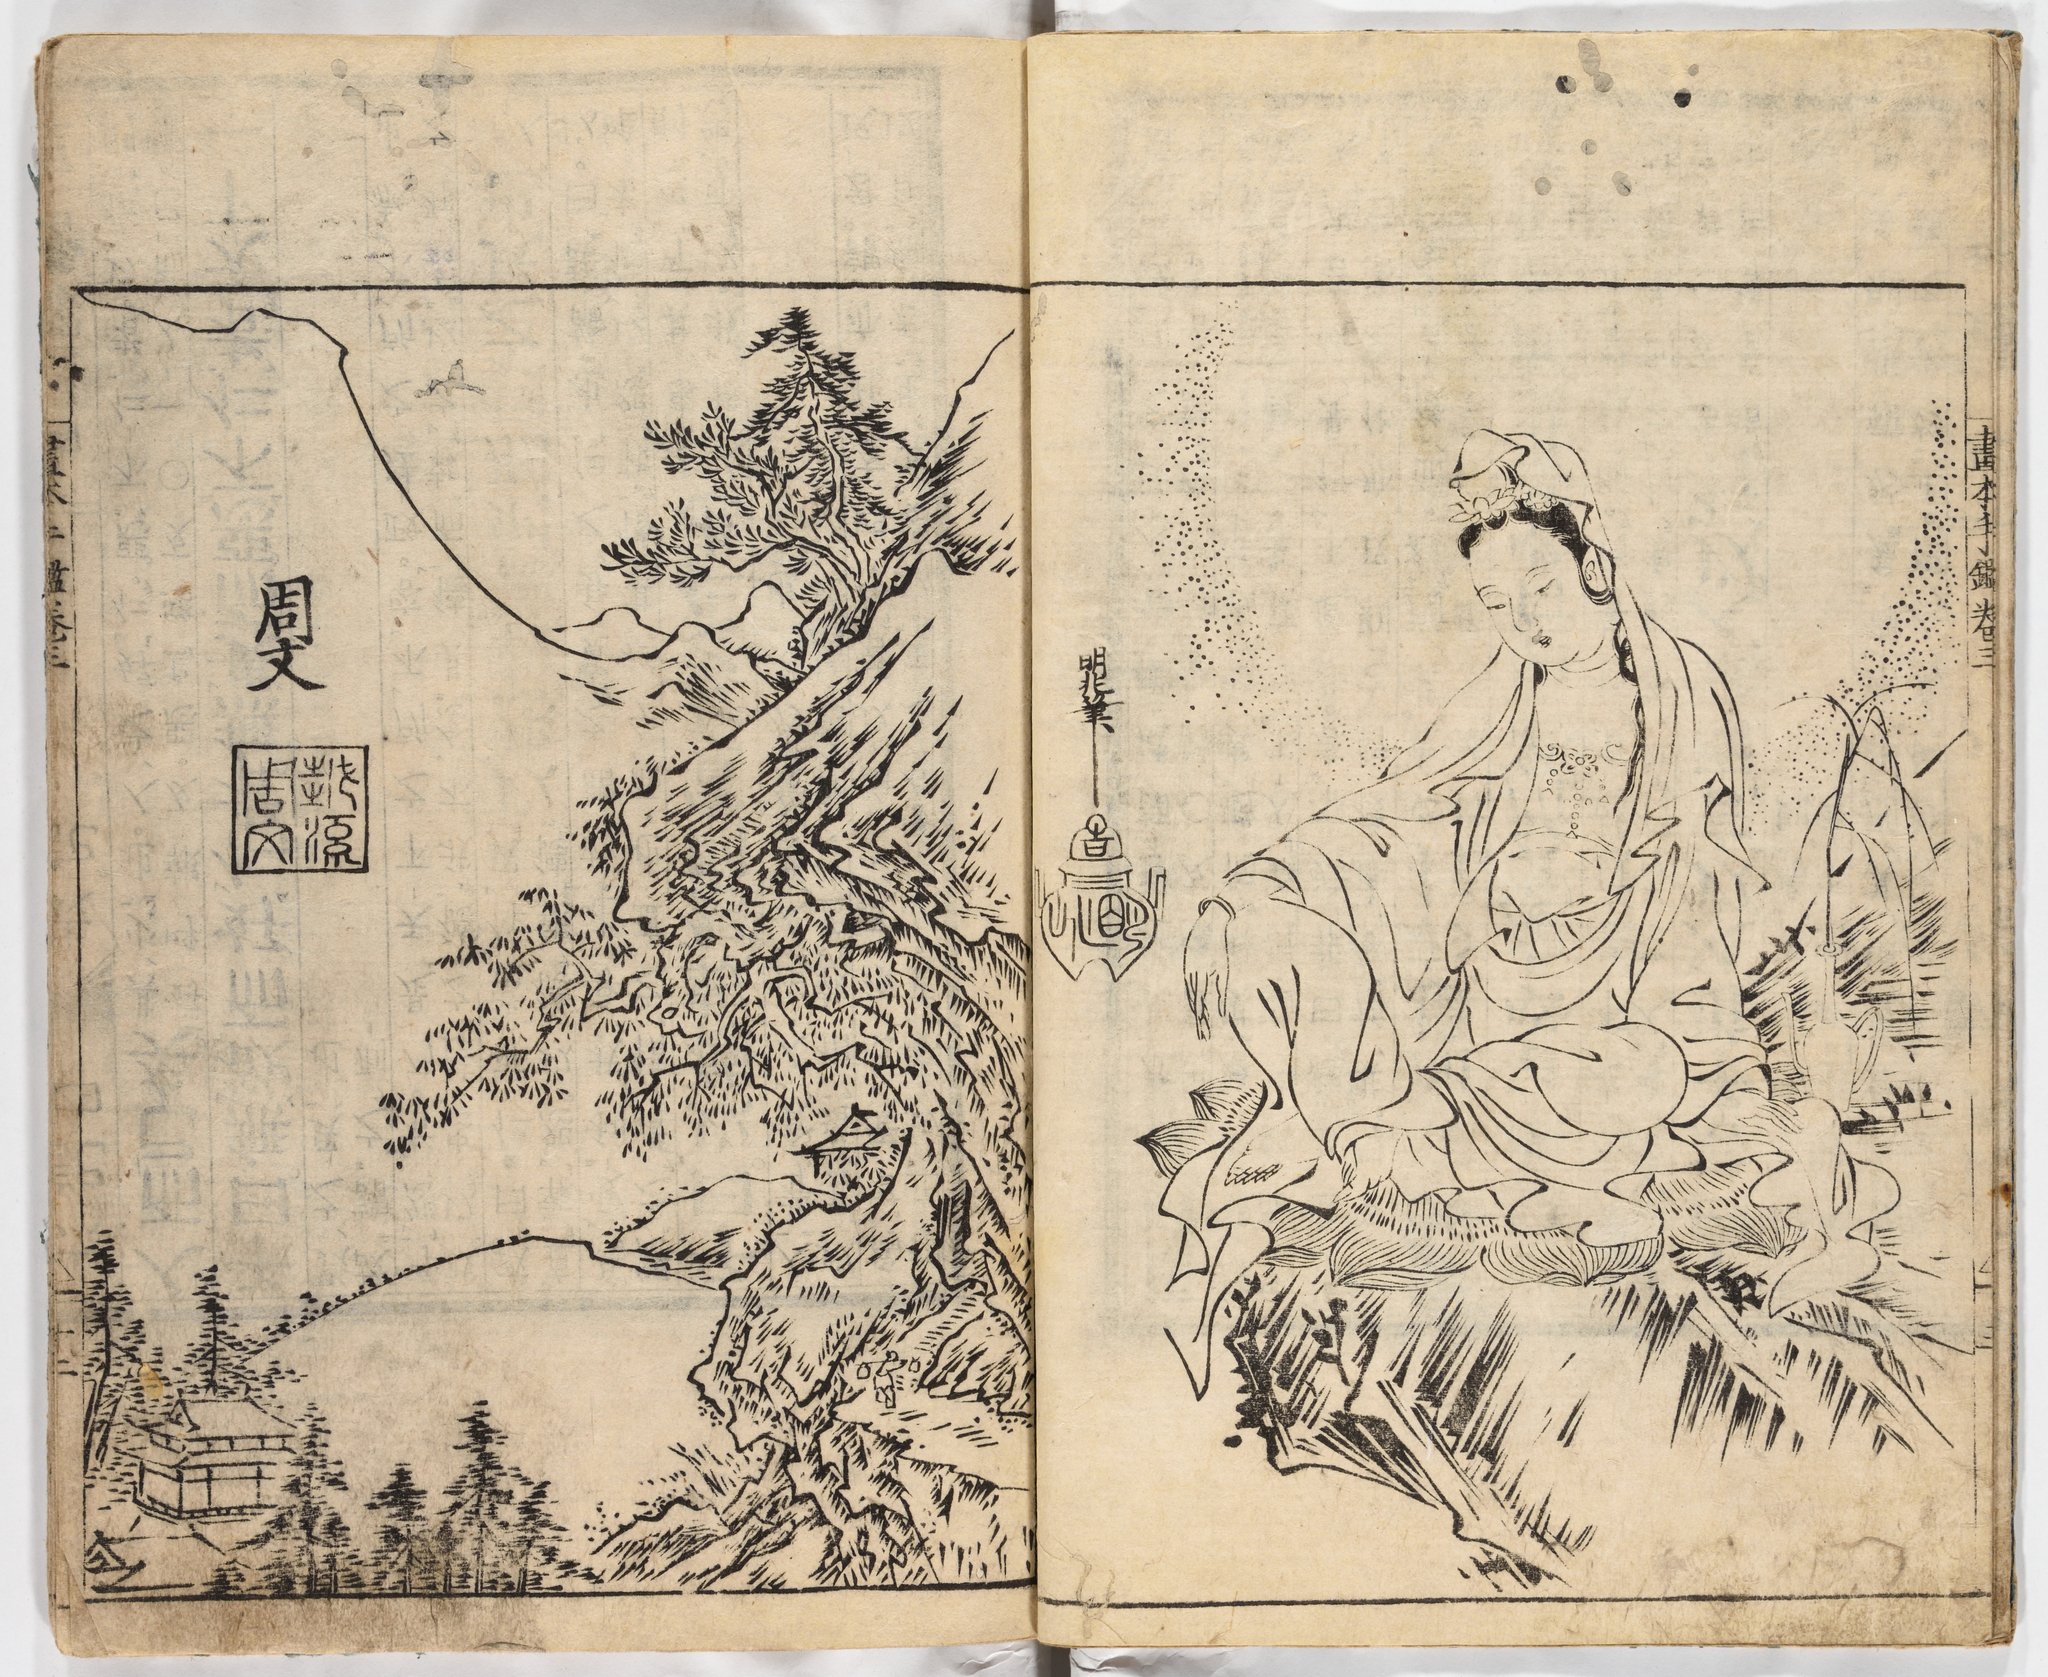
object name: illustrated book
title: Meijin gafu, Vol. 3 (Famous Painters)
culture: japanese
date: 1615-1868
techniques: woodblock print